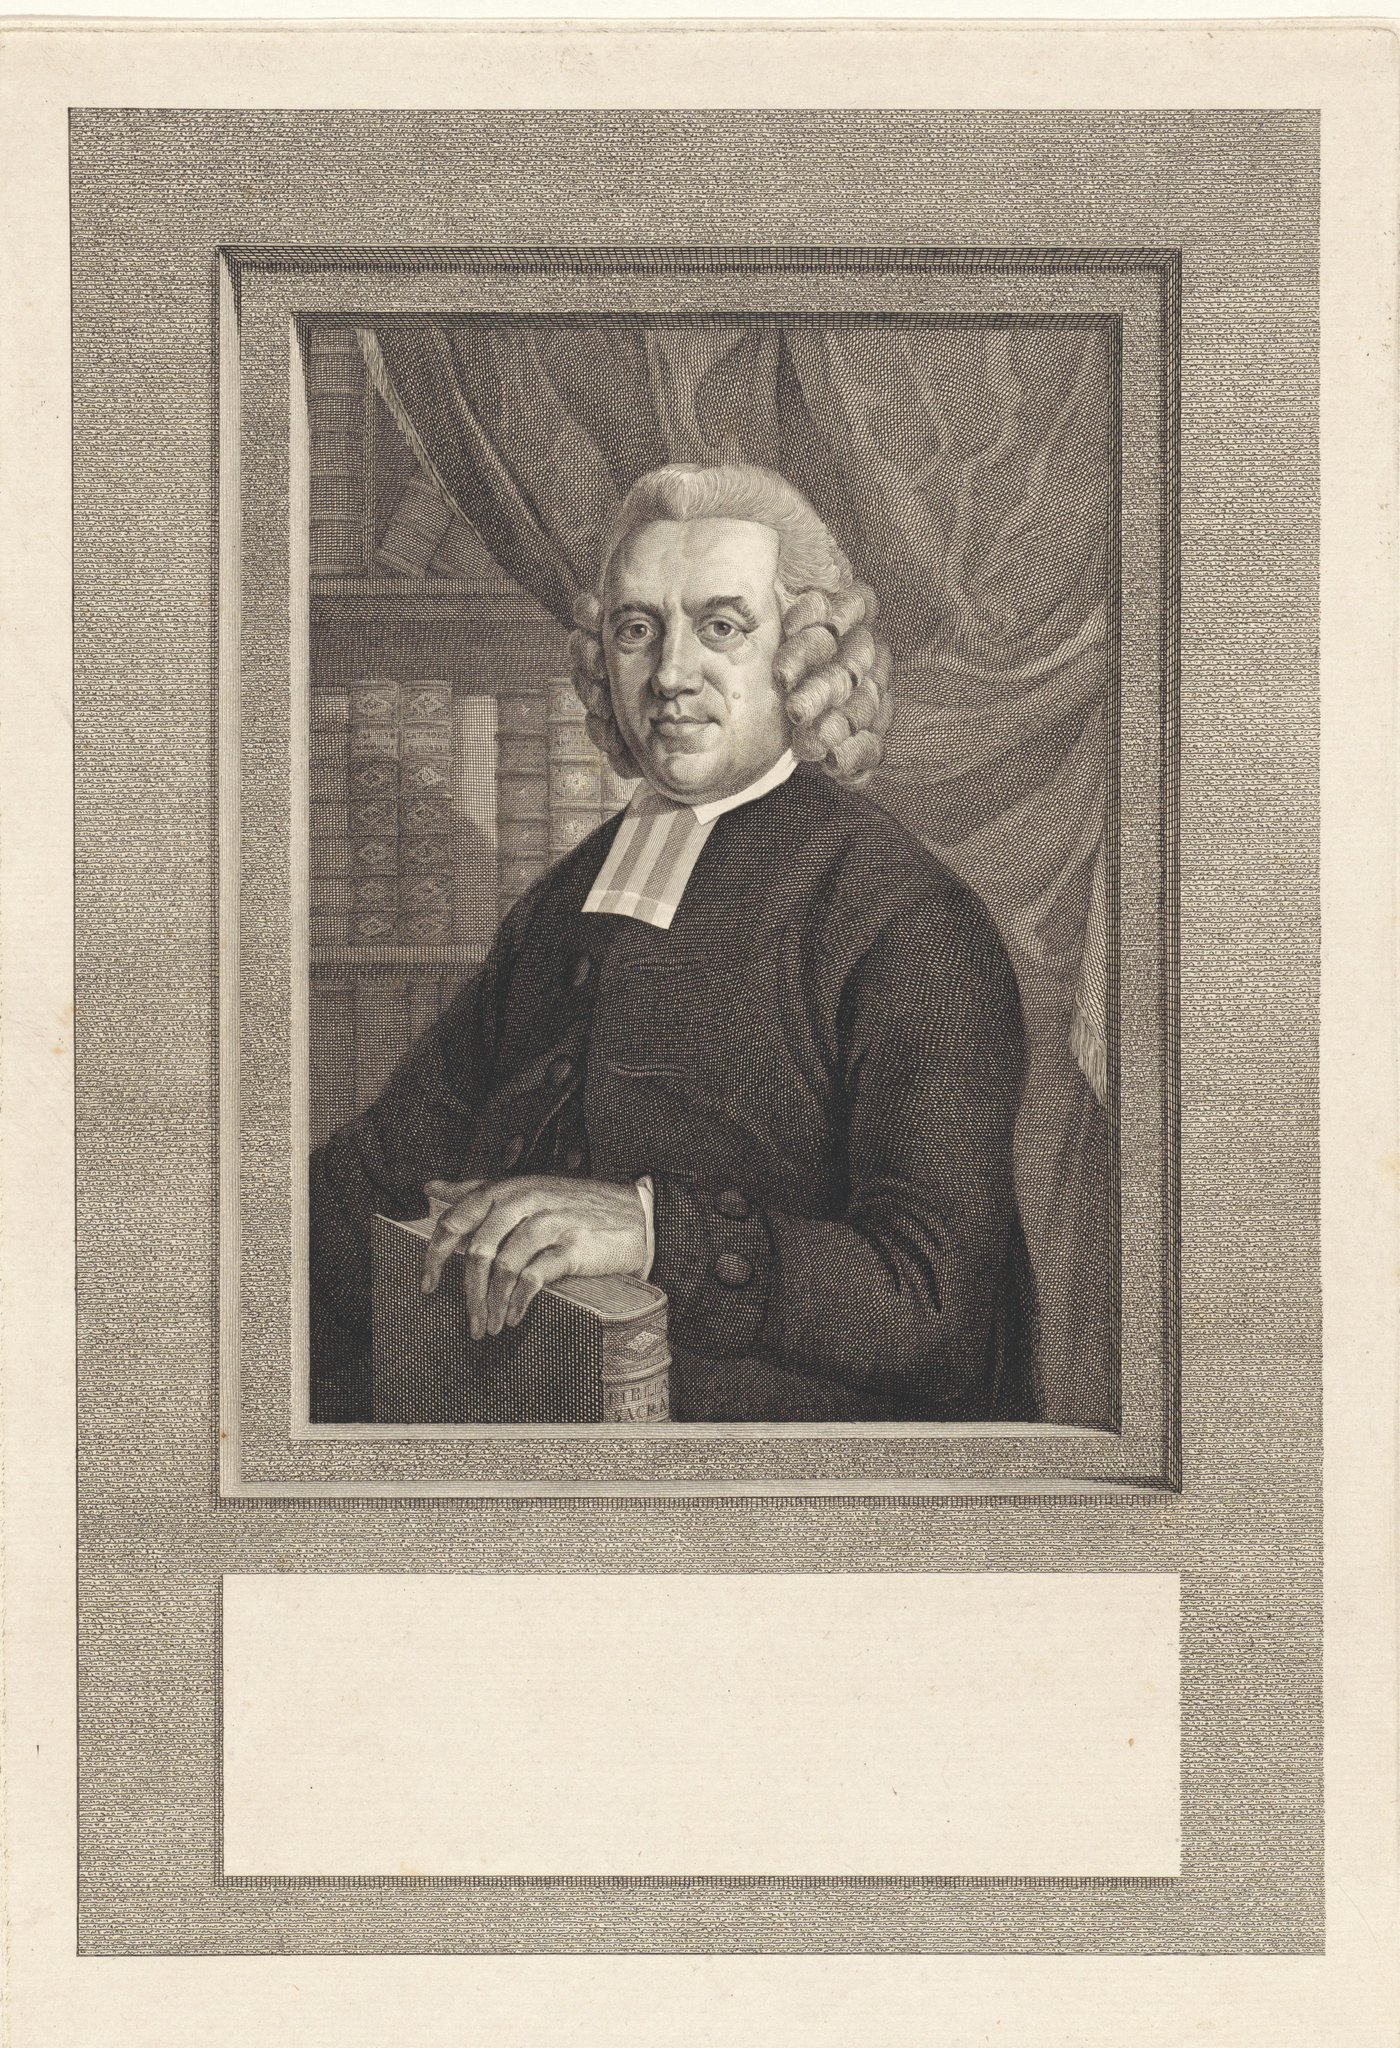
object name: print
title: Portret van Petrus Haack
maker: reinier vinkeles (i)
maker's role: draughtsman, print maker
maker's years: 1741-1816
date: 1791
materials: paper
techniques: engraving, etching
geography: amsterdam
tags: brielle, petrus haack, study; 'studiolo'; library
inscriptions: collector's mark: Lugt 2228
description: Portret van Petrus Haack, dichter en predikant te Amsterdam.